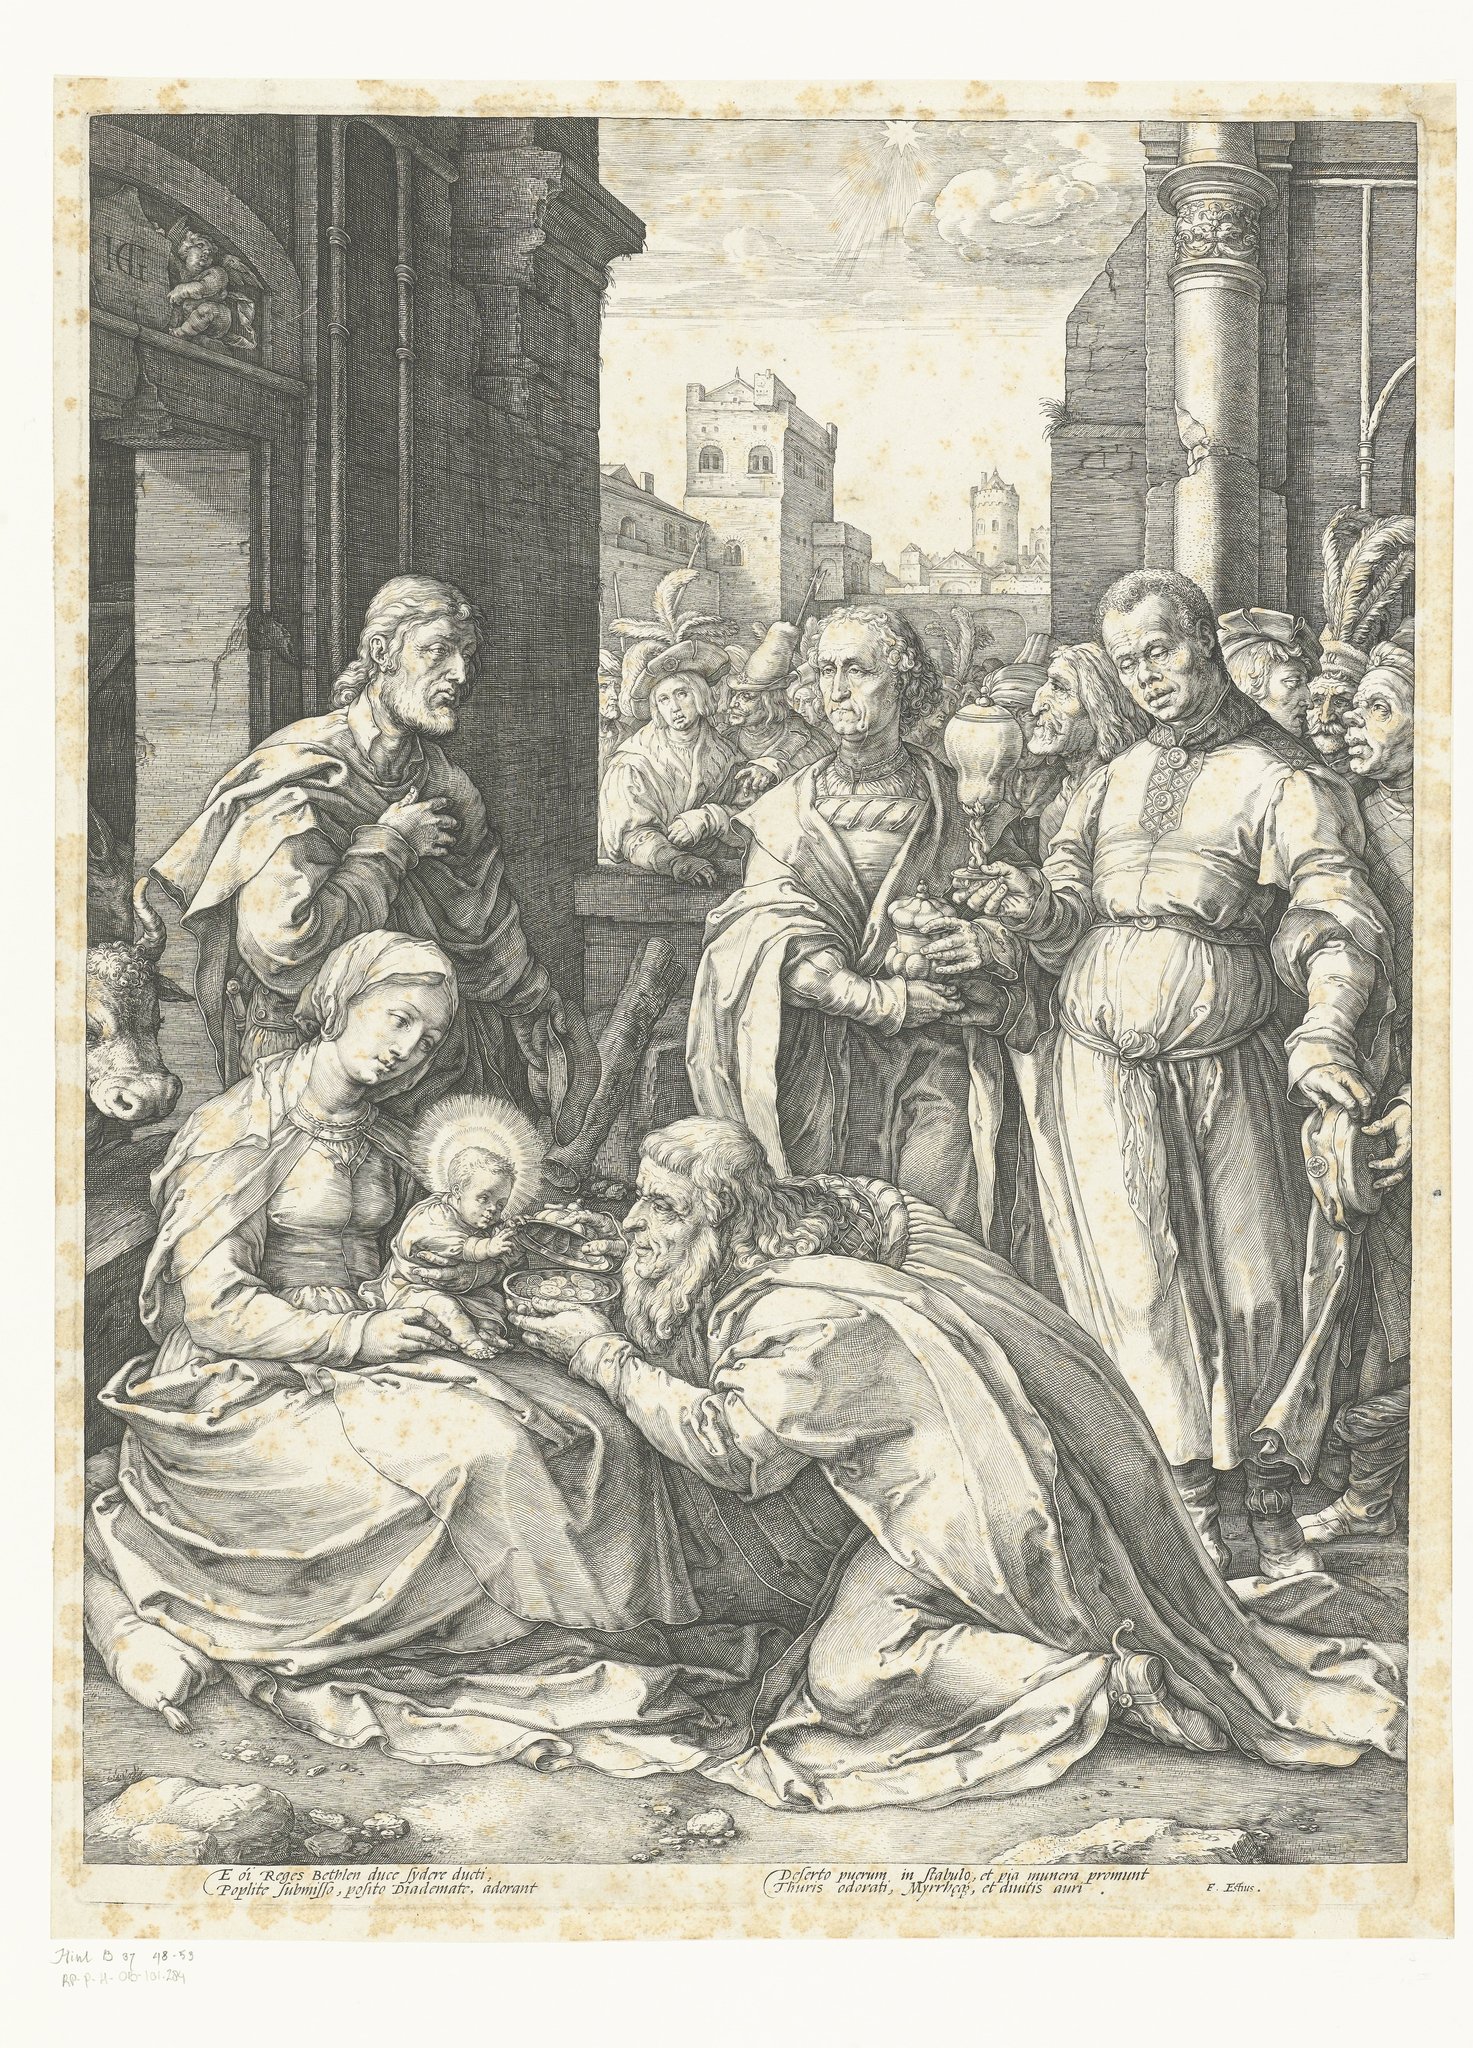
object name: print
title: De aanbidding der koningen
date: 1593-1594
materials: paper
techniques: engraving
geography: haarlem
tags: adoration of the kings: the wise men present their gifts to the christ-child (gold, frankincense and myrrh)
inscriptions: collector's mark: ‘Hinloopen’, collector's mark: Lugt 11, collector's mark: Lugt 10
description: Maria en Jozef tonen, gezeten in/bij een ruïne, hun pasgeboren kind aan de drie koningen of wijzen uit het Oosten en hun gevolg. Onder de voorstelling vier Latijnse versregels. Deze prent is onderdeel van een serie van zes prenten met scènes uit het vroege leven van Maria. Die worden de 'Meesterstukken' genoemd, omdat Goltzius er het werk van verschillende illustere voorgangers in heeft nagebootst.